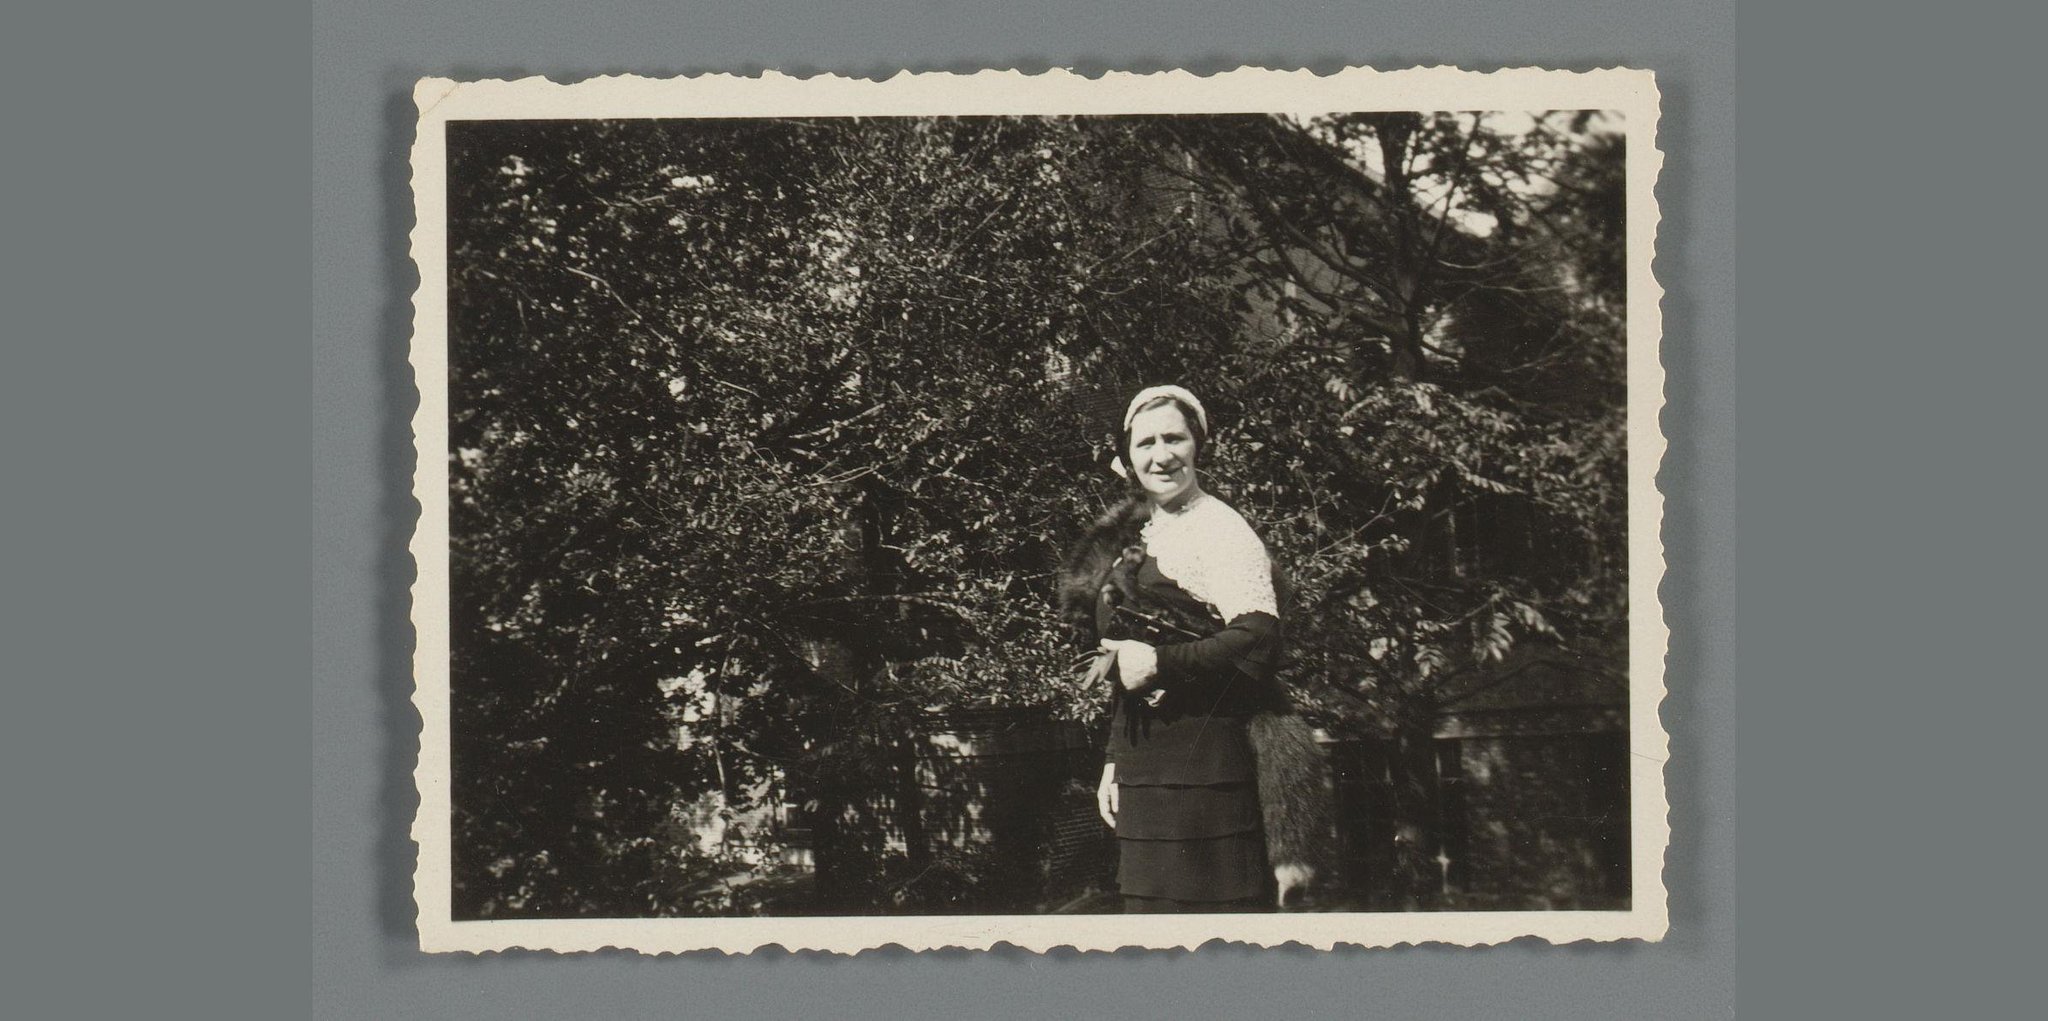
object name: photograph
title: Portret van Cato Merks bij een boom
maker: Anonymous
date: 1920-1940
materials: paper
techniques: gelatin silver print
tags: historical persons - bb - woman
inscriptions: stamp: ‘W’, number: ‘33’